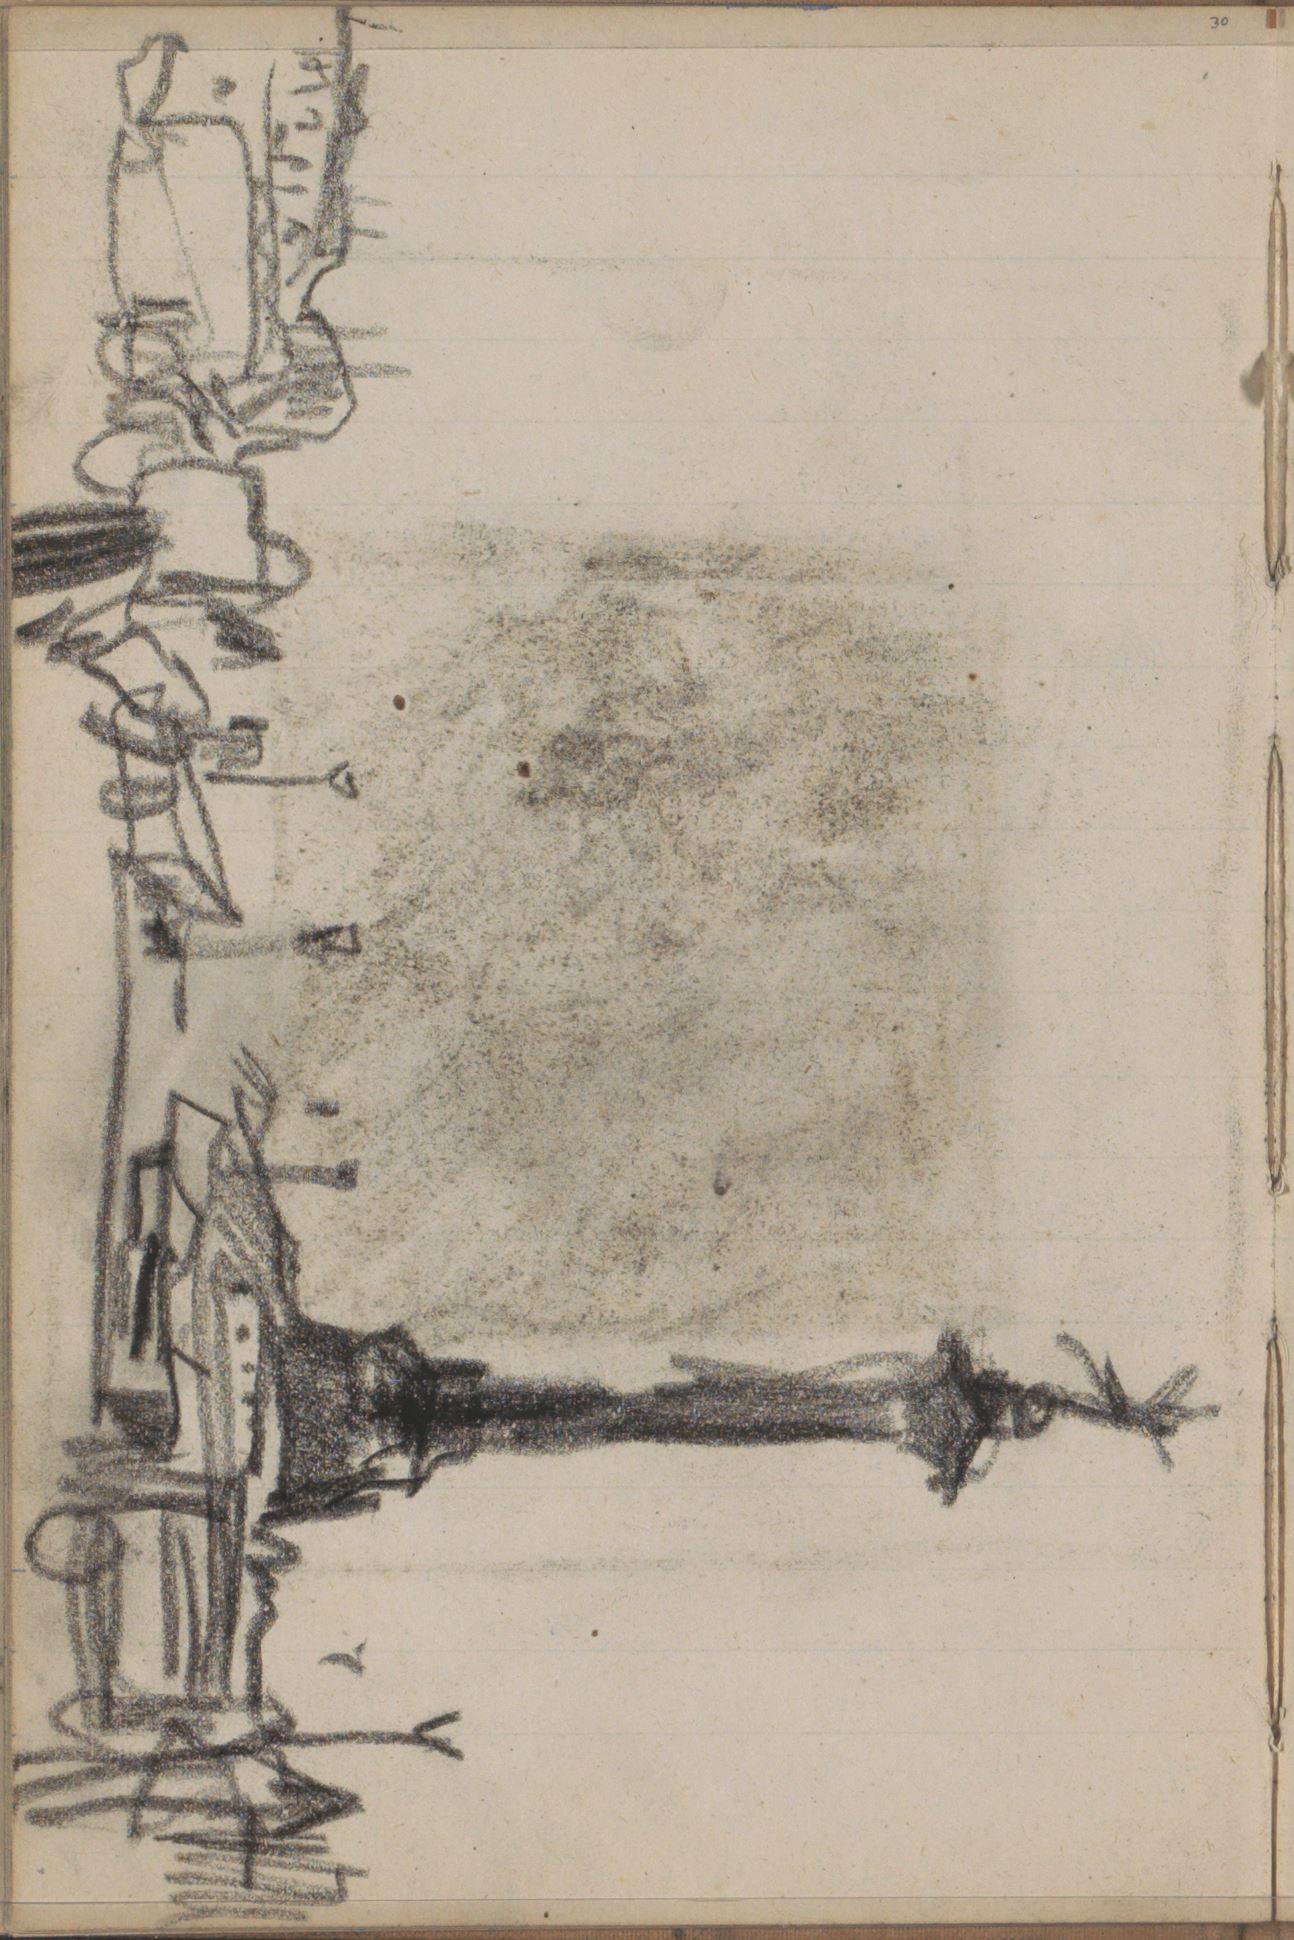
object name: sketchbook leaf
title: Zuil met beeldhouwwerk op een plein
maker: marius bauer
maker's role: draughtsman, print maker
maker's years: 1867-1932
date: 1888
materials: chalk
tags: monument, statue, street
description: Mogelijk een monument in Wenen of Straatsburg. Pagina 30 uit een schetsboek met 49 bladen.